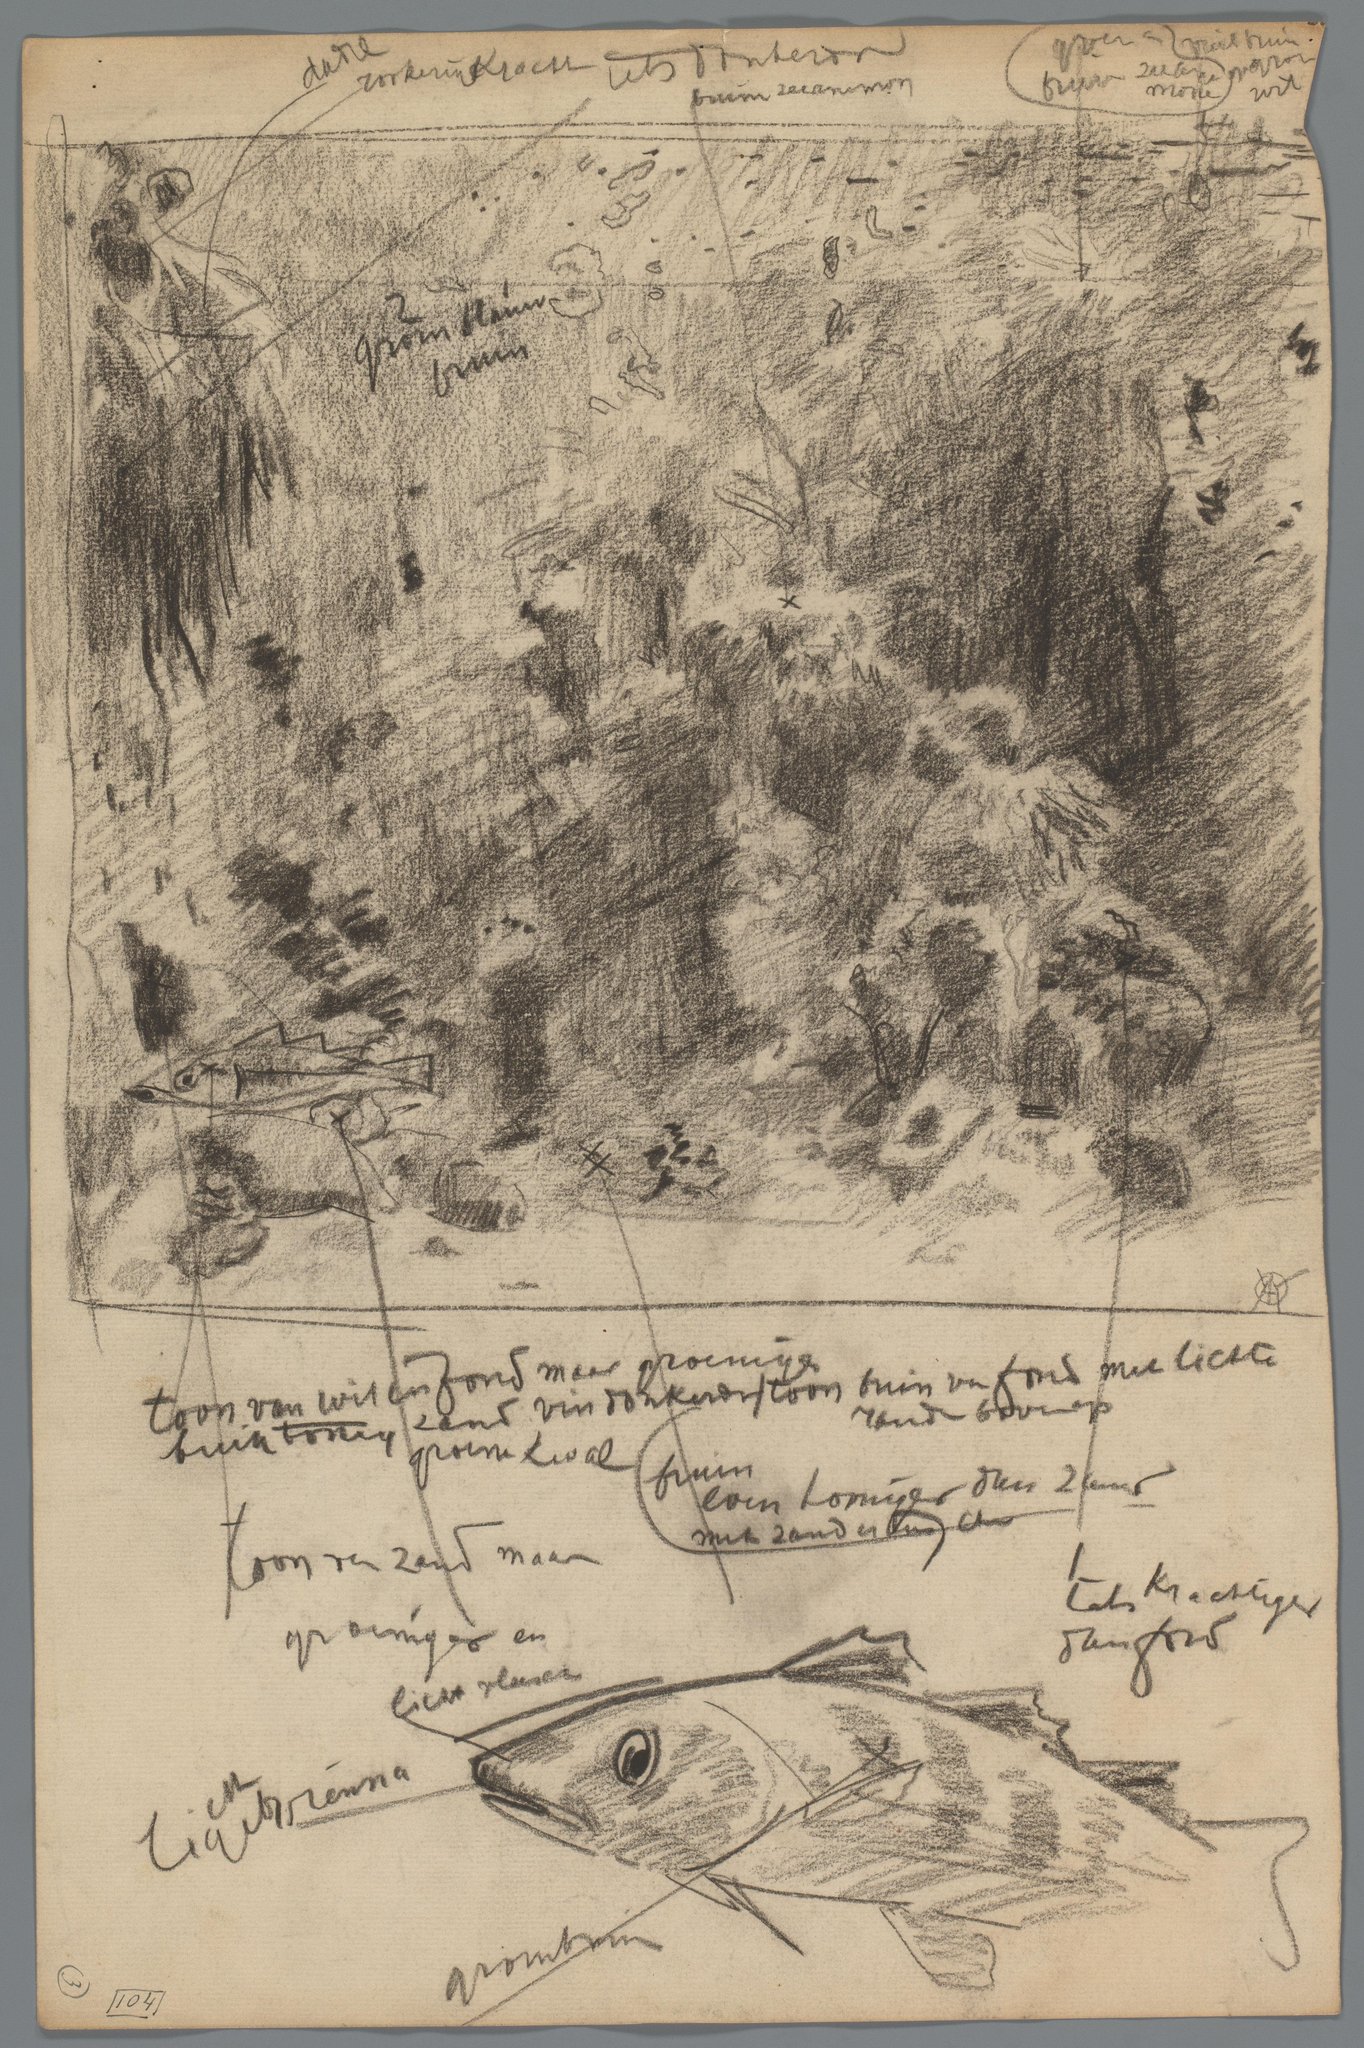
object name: drawing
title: Studie van een aquarium met een vis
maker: gerrit willem dijsselhof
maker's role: designer, draughtsman, print maker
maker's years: 1866-1924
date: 1876-1924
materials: chalk, paper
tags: aquarium, bony fishes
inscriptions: number: ‘3’, number: ‘104’